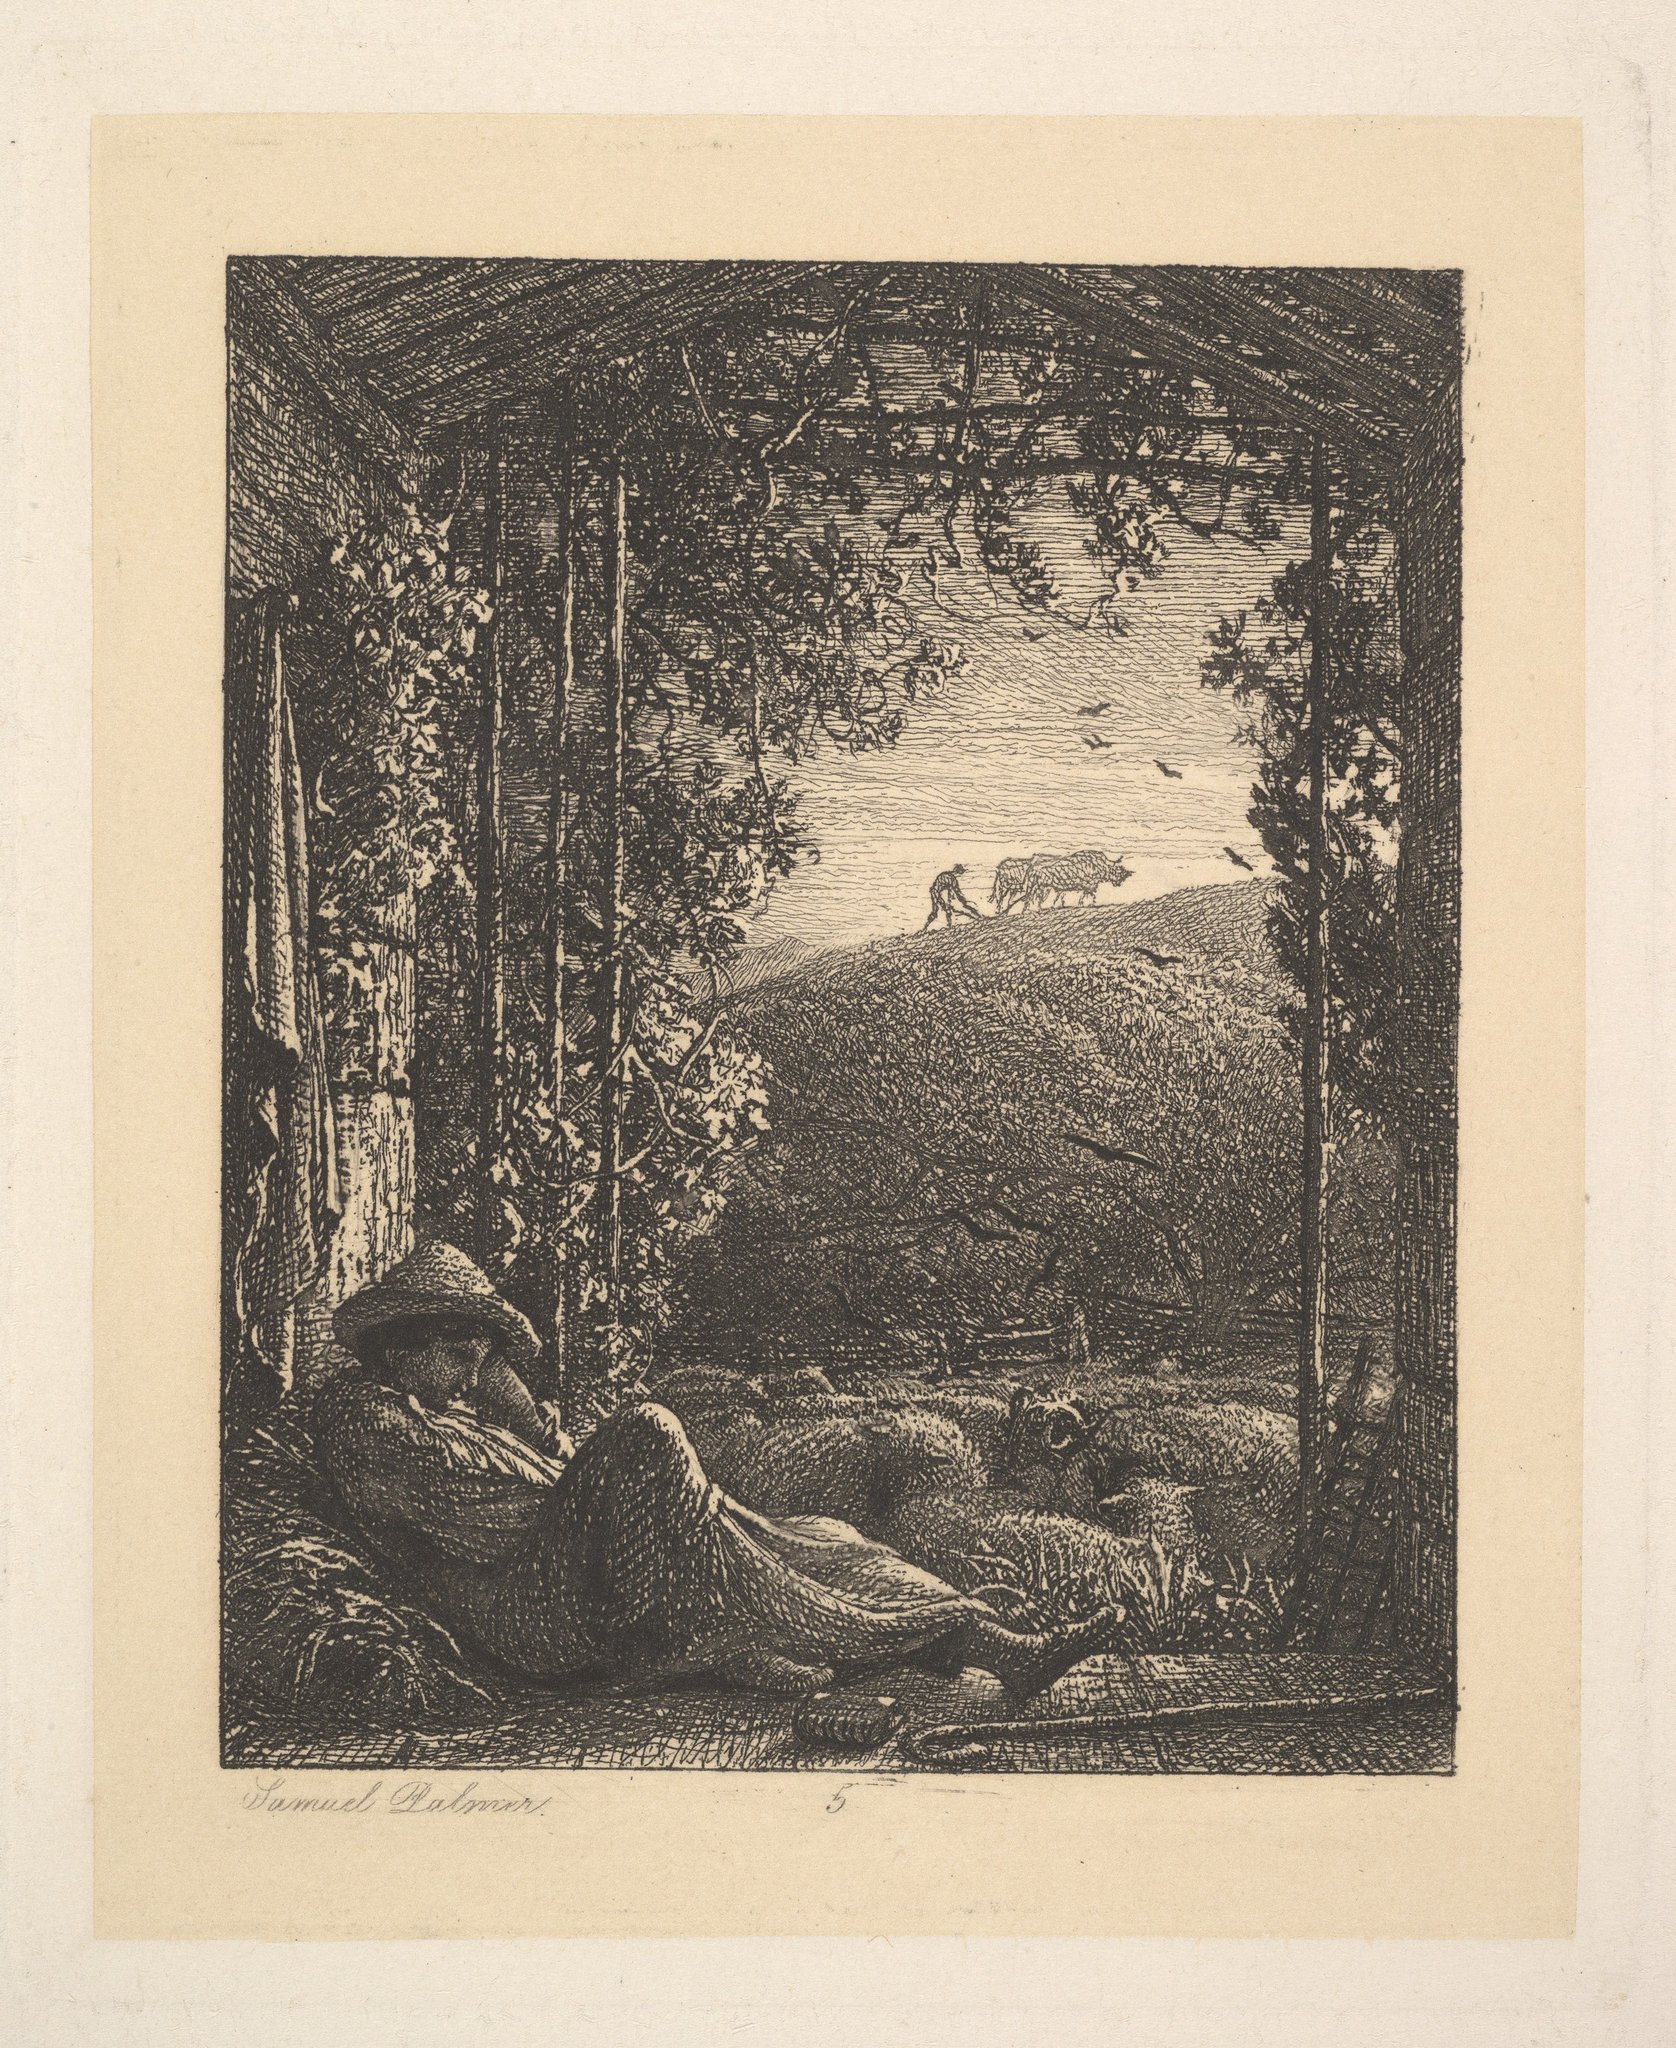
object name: print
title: The Sleeping Shepherd, Early Morning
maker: samuel palmer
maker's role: artist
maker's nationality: british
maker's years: 1805-1881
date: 1857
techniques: printmaking, etching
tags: sleeping,morning,shepherds